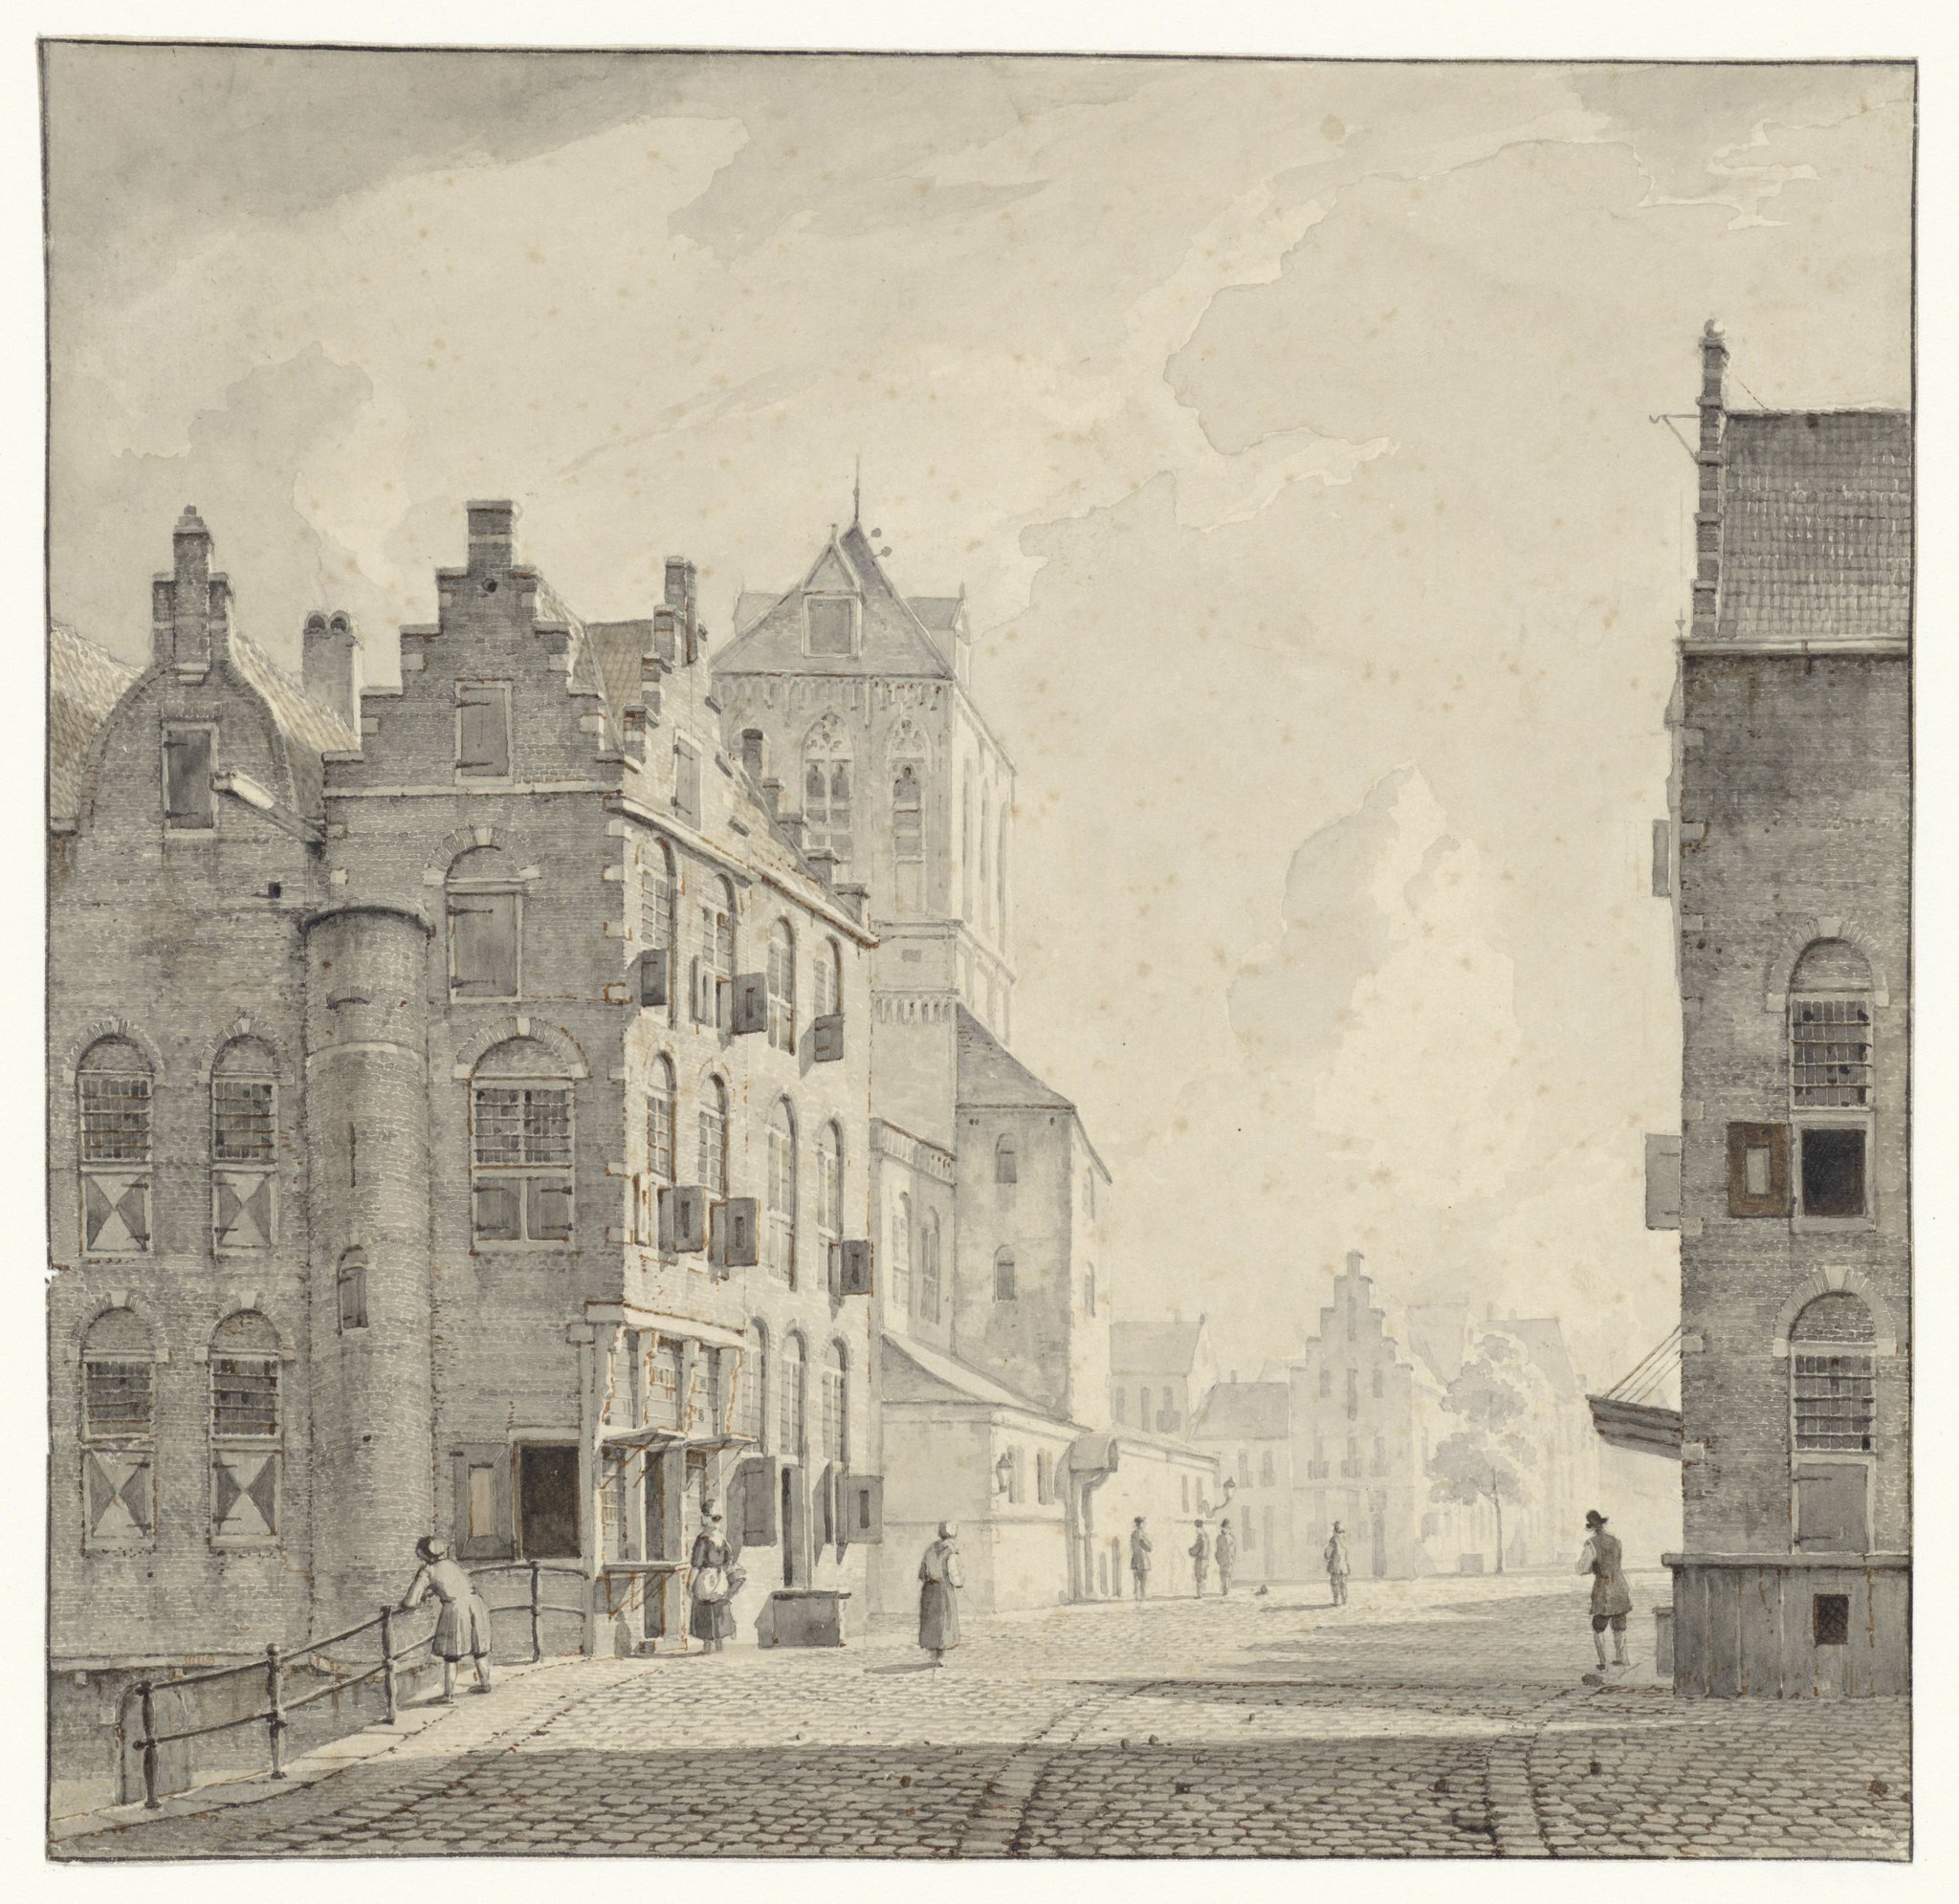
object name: drawing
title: Aan de markt te Delft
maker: kasparus karsen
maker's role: draughtsman, painter, print maker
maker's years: 1810-1896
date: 1820-1896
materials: ink, paper, pencil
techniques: brush, pen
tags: square, place, circus, etc., delft